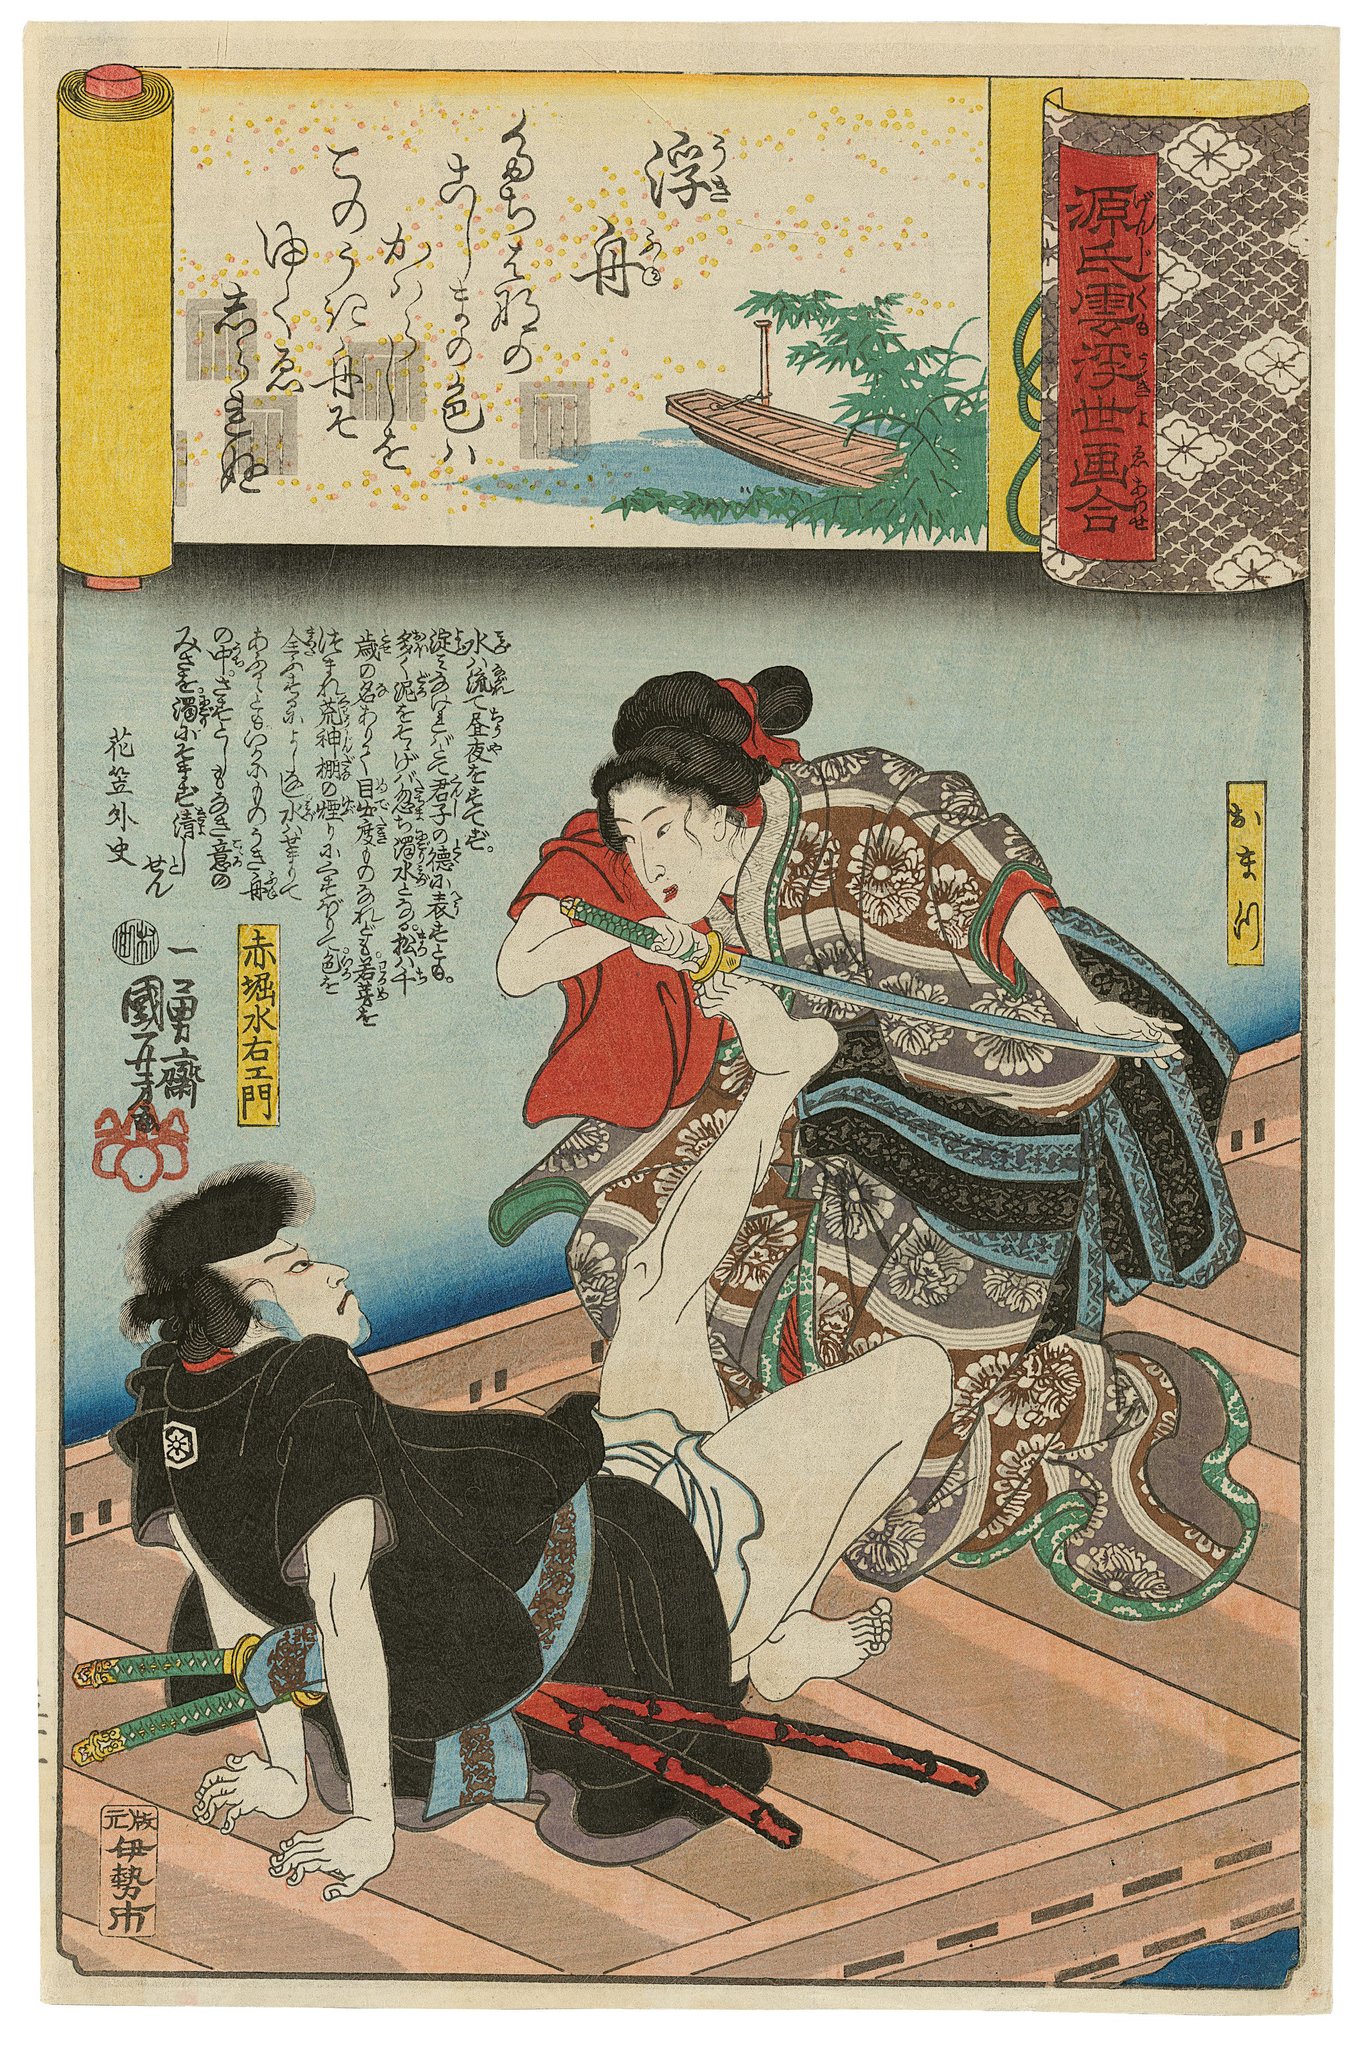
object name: print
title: “‘A Boat Cast Adrift’ (Ukifune): Omatsu and Akabori Mizuemon,” from the series Scenes amid Genji Clouds Matched with Ukiyo-e Pictures (Genji-gumo ukiyo e-awase)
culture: japanese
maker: utagawa kuniyoshi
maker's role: artist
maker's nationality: japanese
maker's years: 1797-1861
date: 1845-1846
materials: ink, paper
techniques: nishiki e